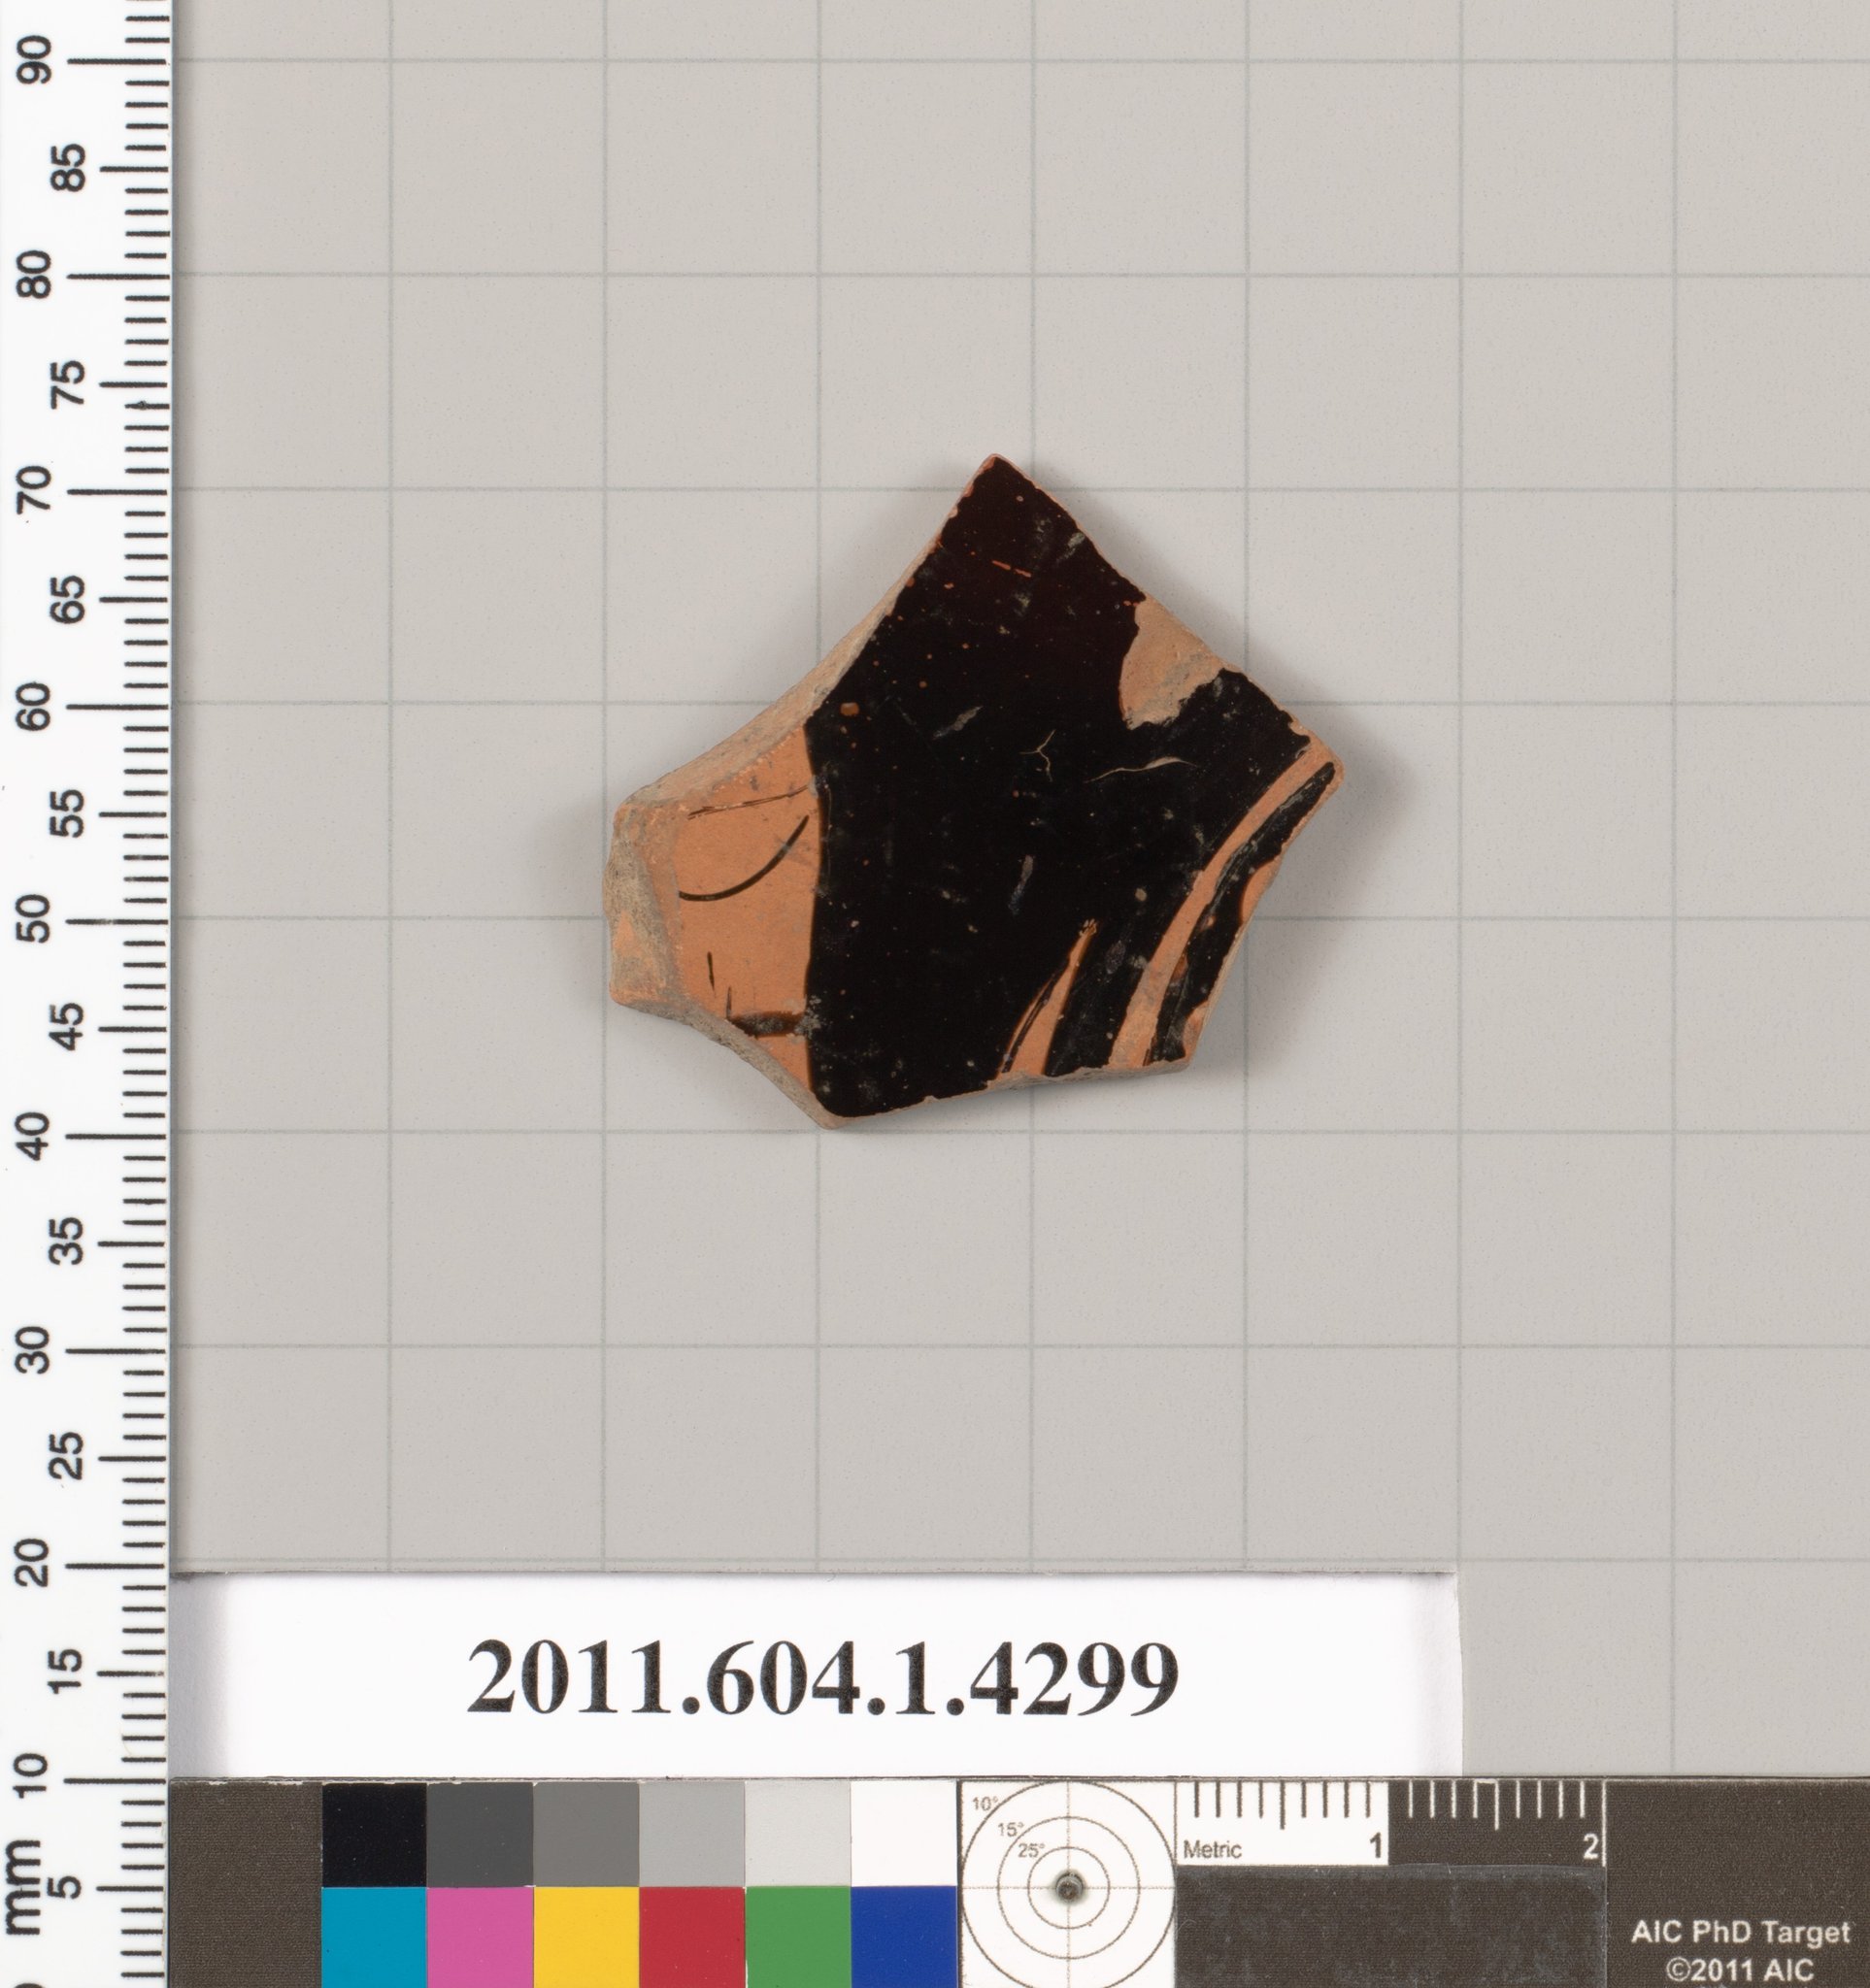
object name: kylix fragment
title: Terracotta fragment of a kylix (drinking cup)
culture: greek, attic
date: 475-451 BCE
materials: terracotta